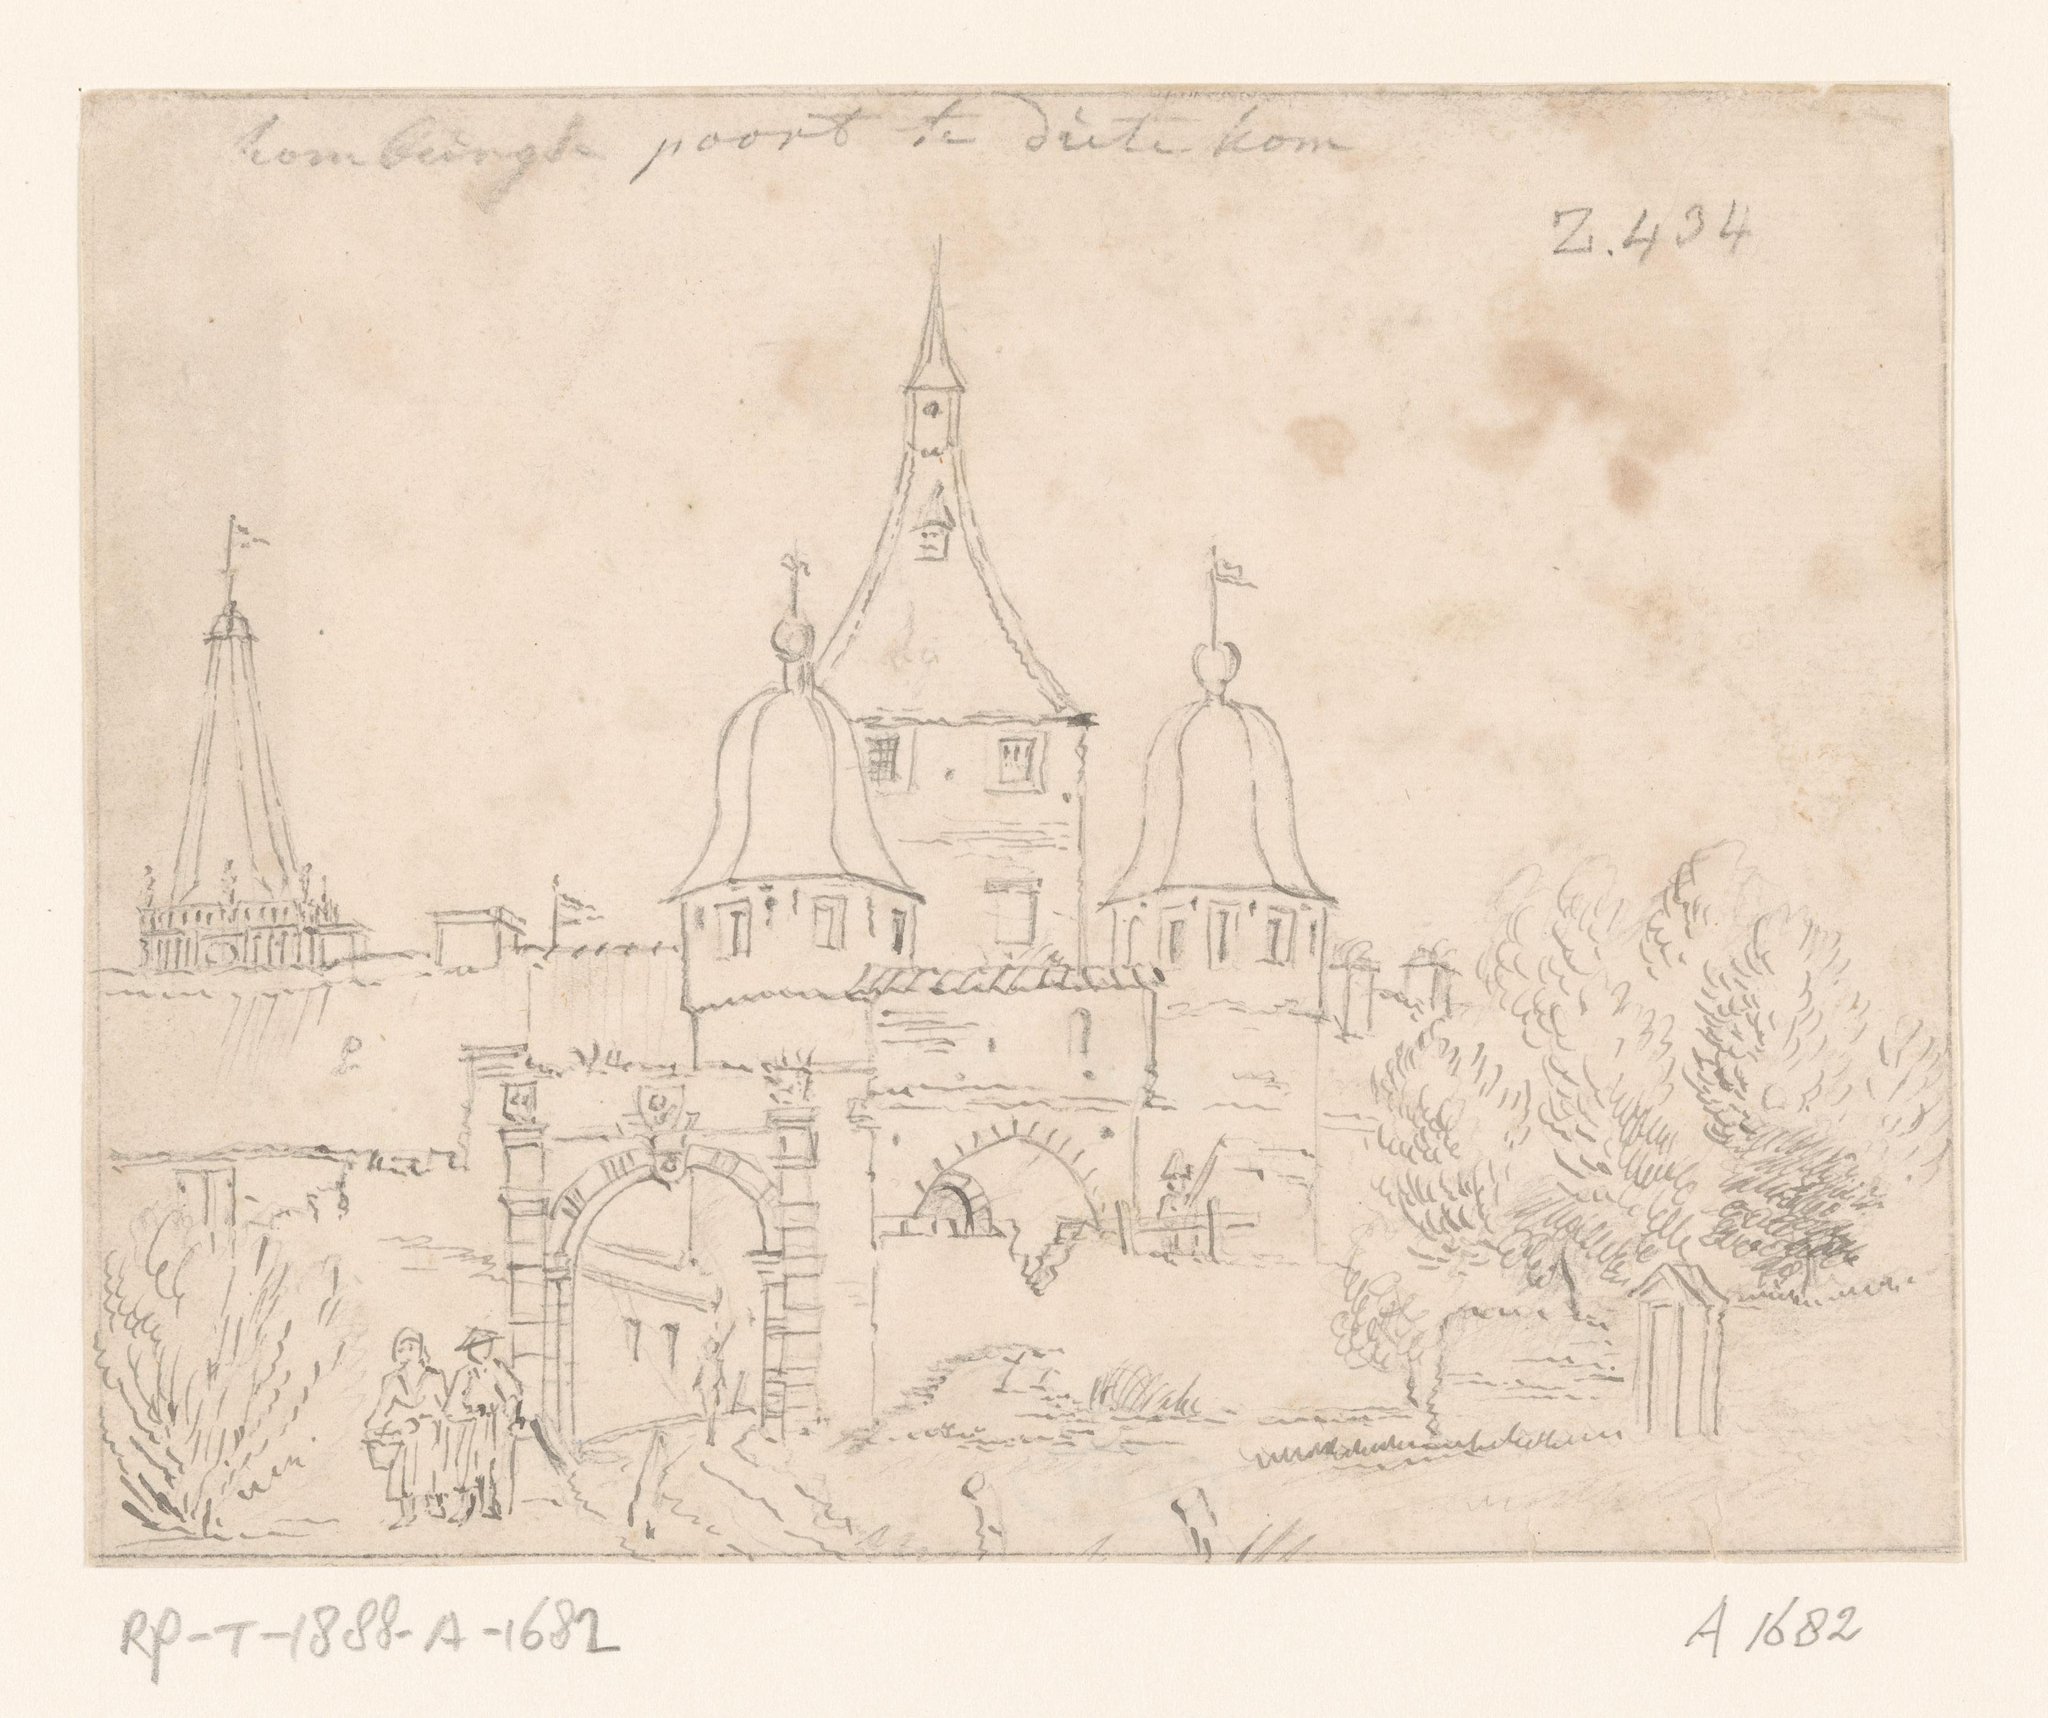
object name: drawing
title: Homburgh poort te Dutekom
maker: cornelis pronk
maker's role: draughtsman, painter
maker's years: 1691-1759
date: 1701-1759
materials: ink, paper, pencil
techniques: pen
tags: city-gate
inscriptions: inscription: ‘Homburgh poort te Dutekom’, collector's mark: Lugt 2228